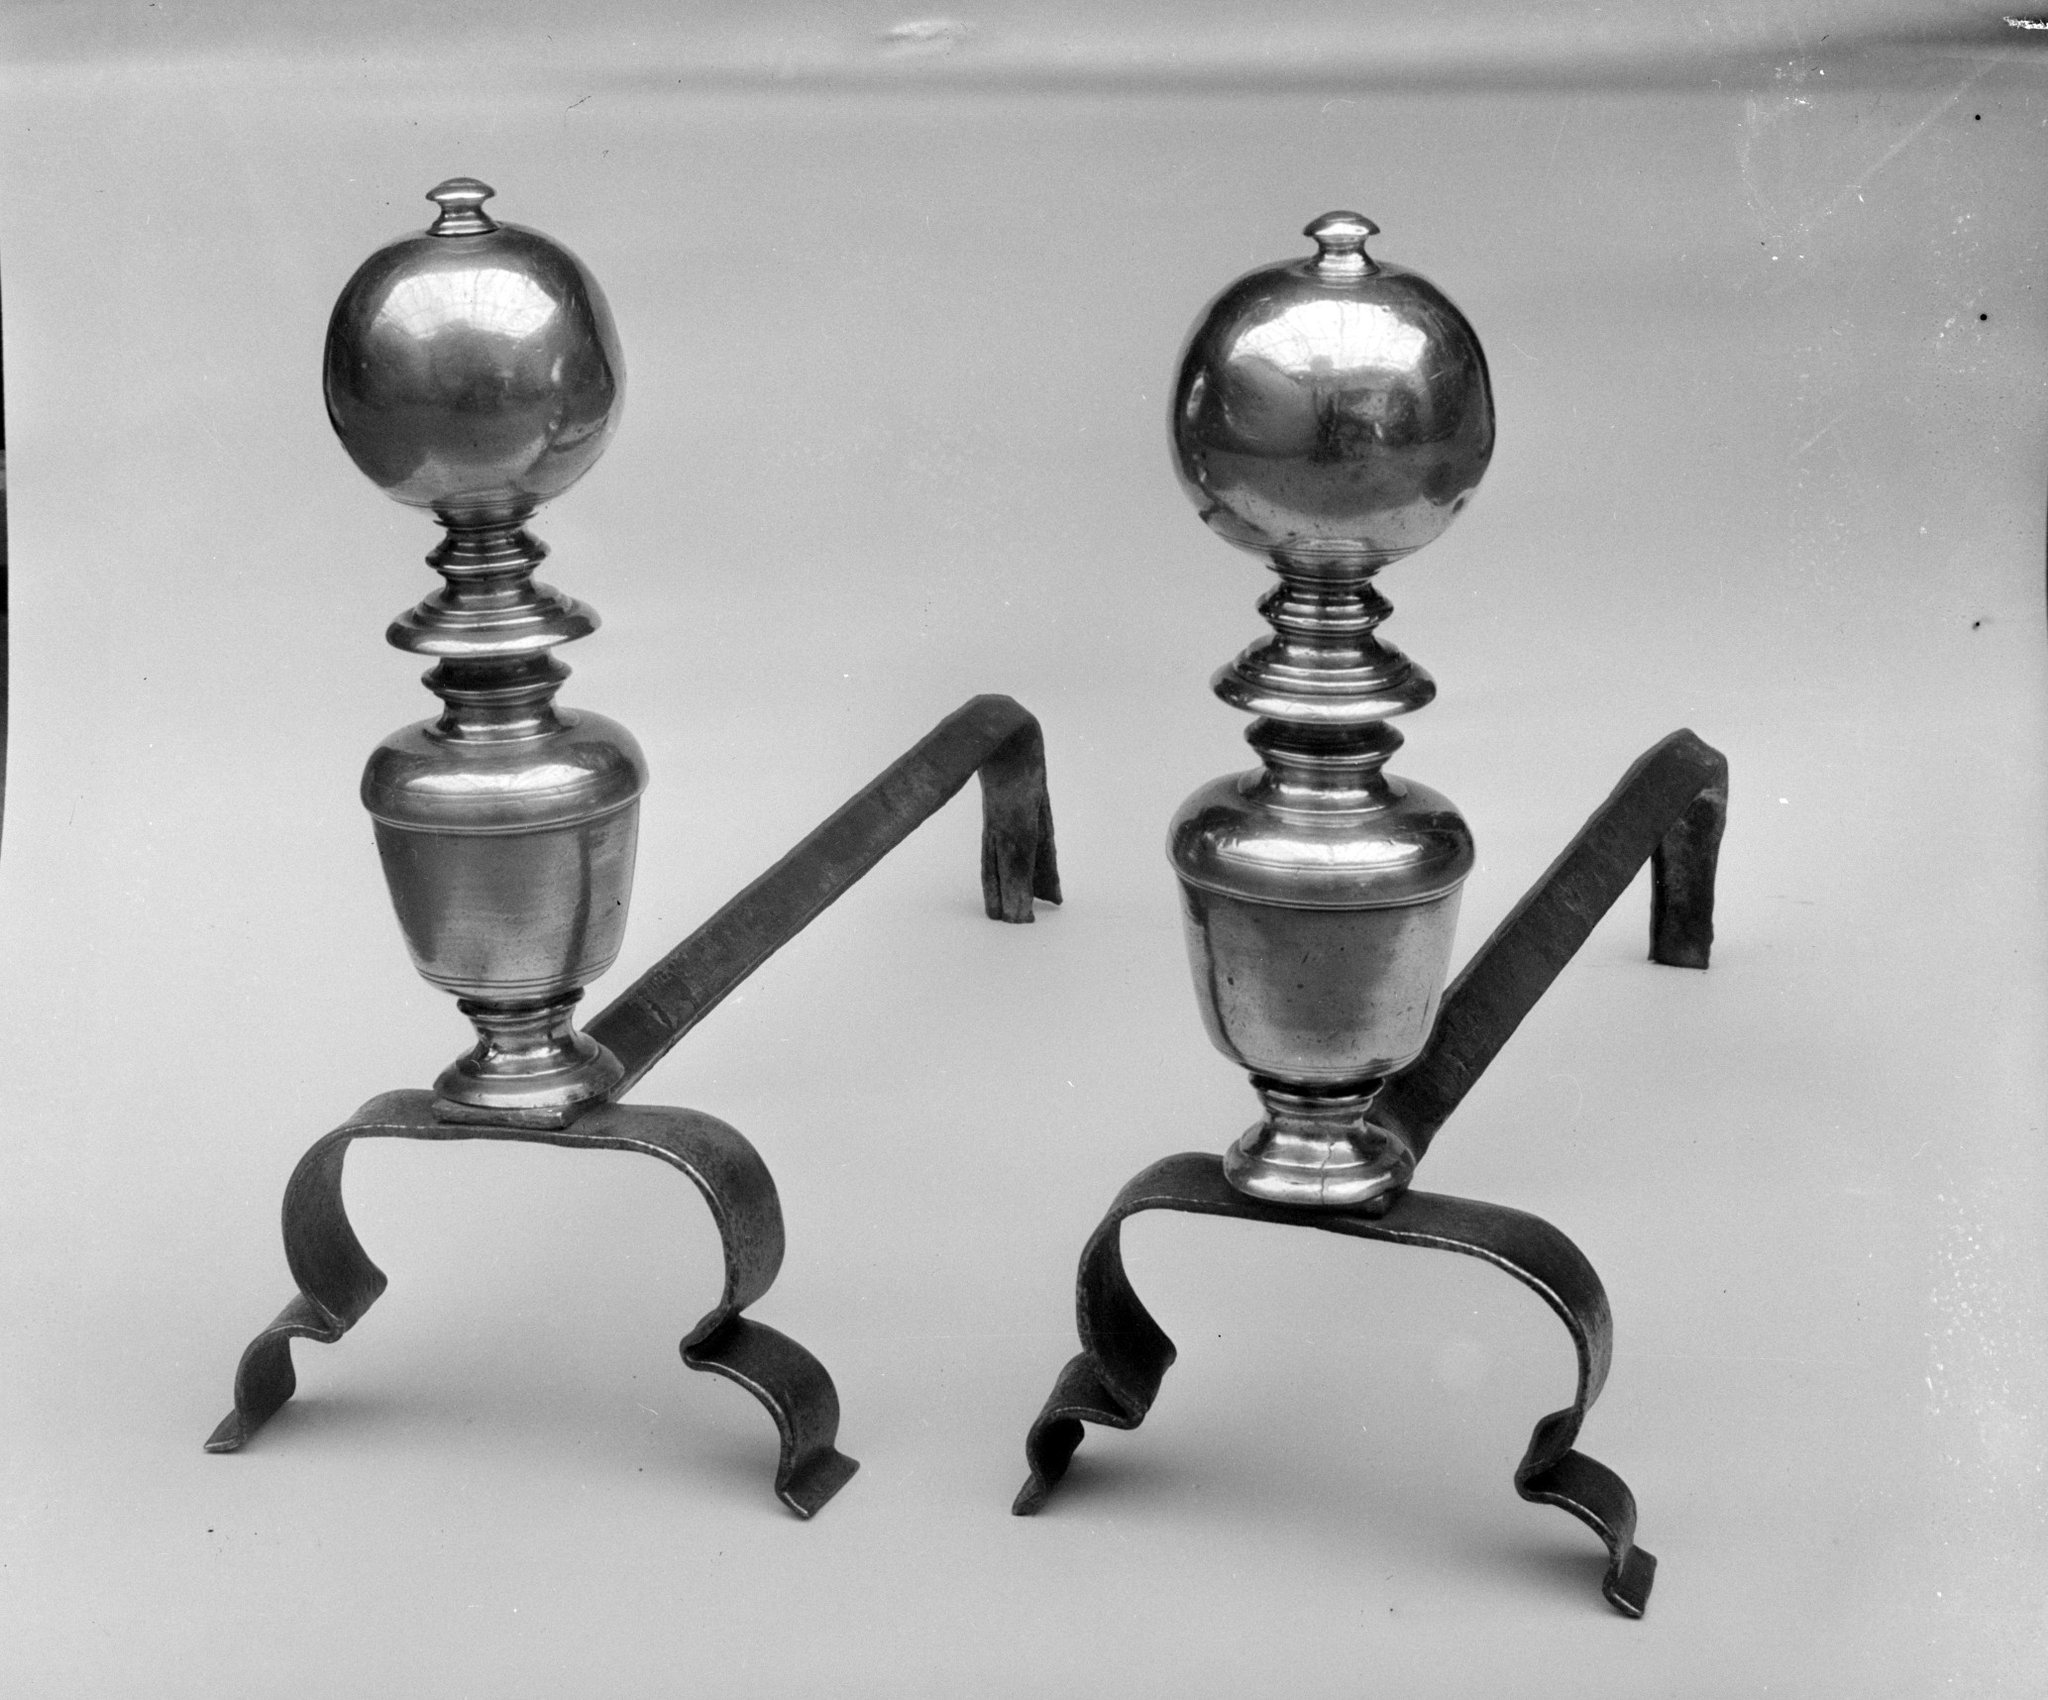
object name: andiron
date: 1700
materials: brass, iron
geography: spain